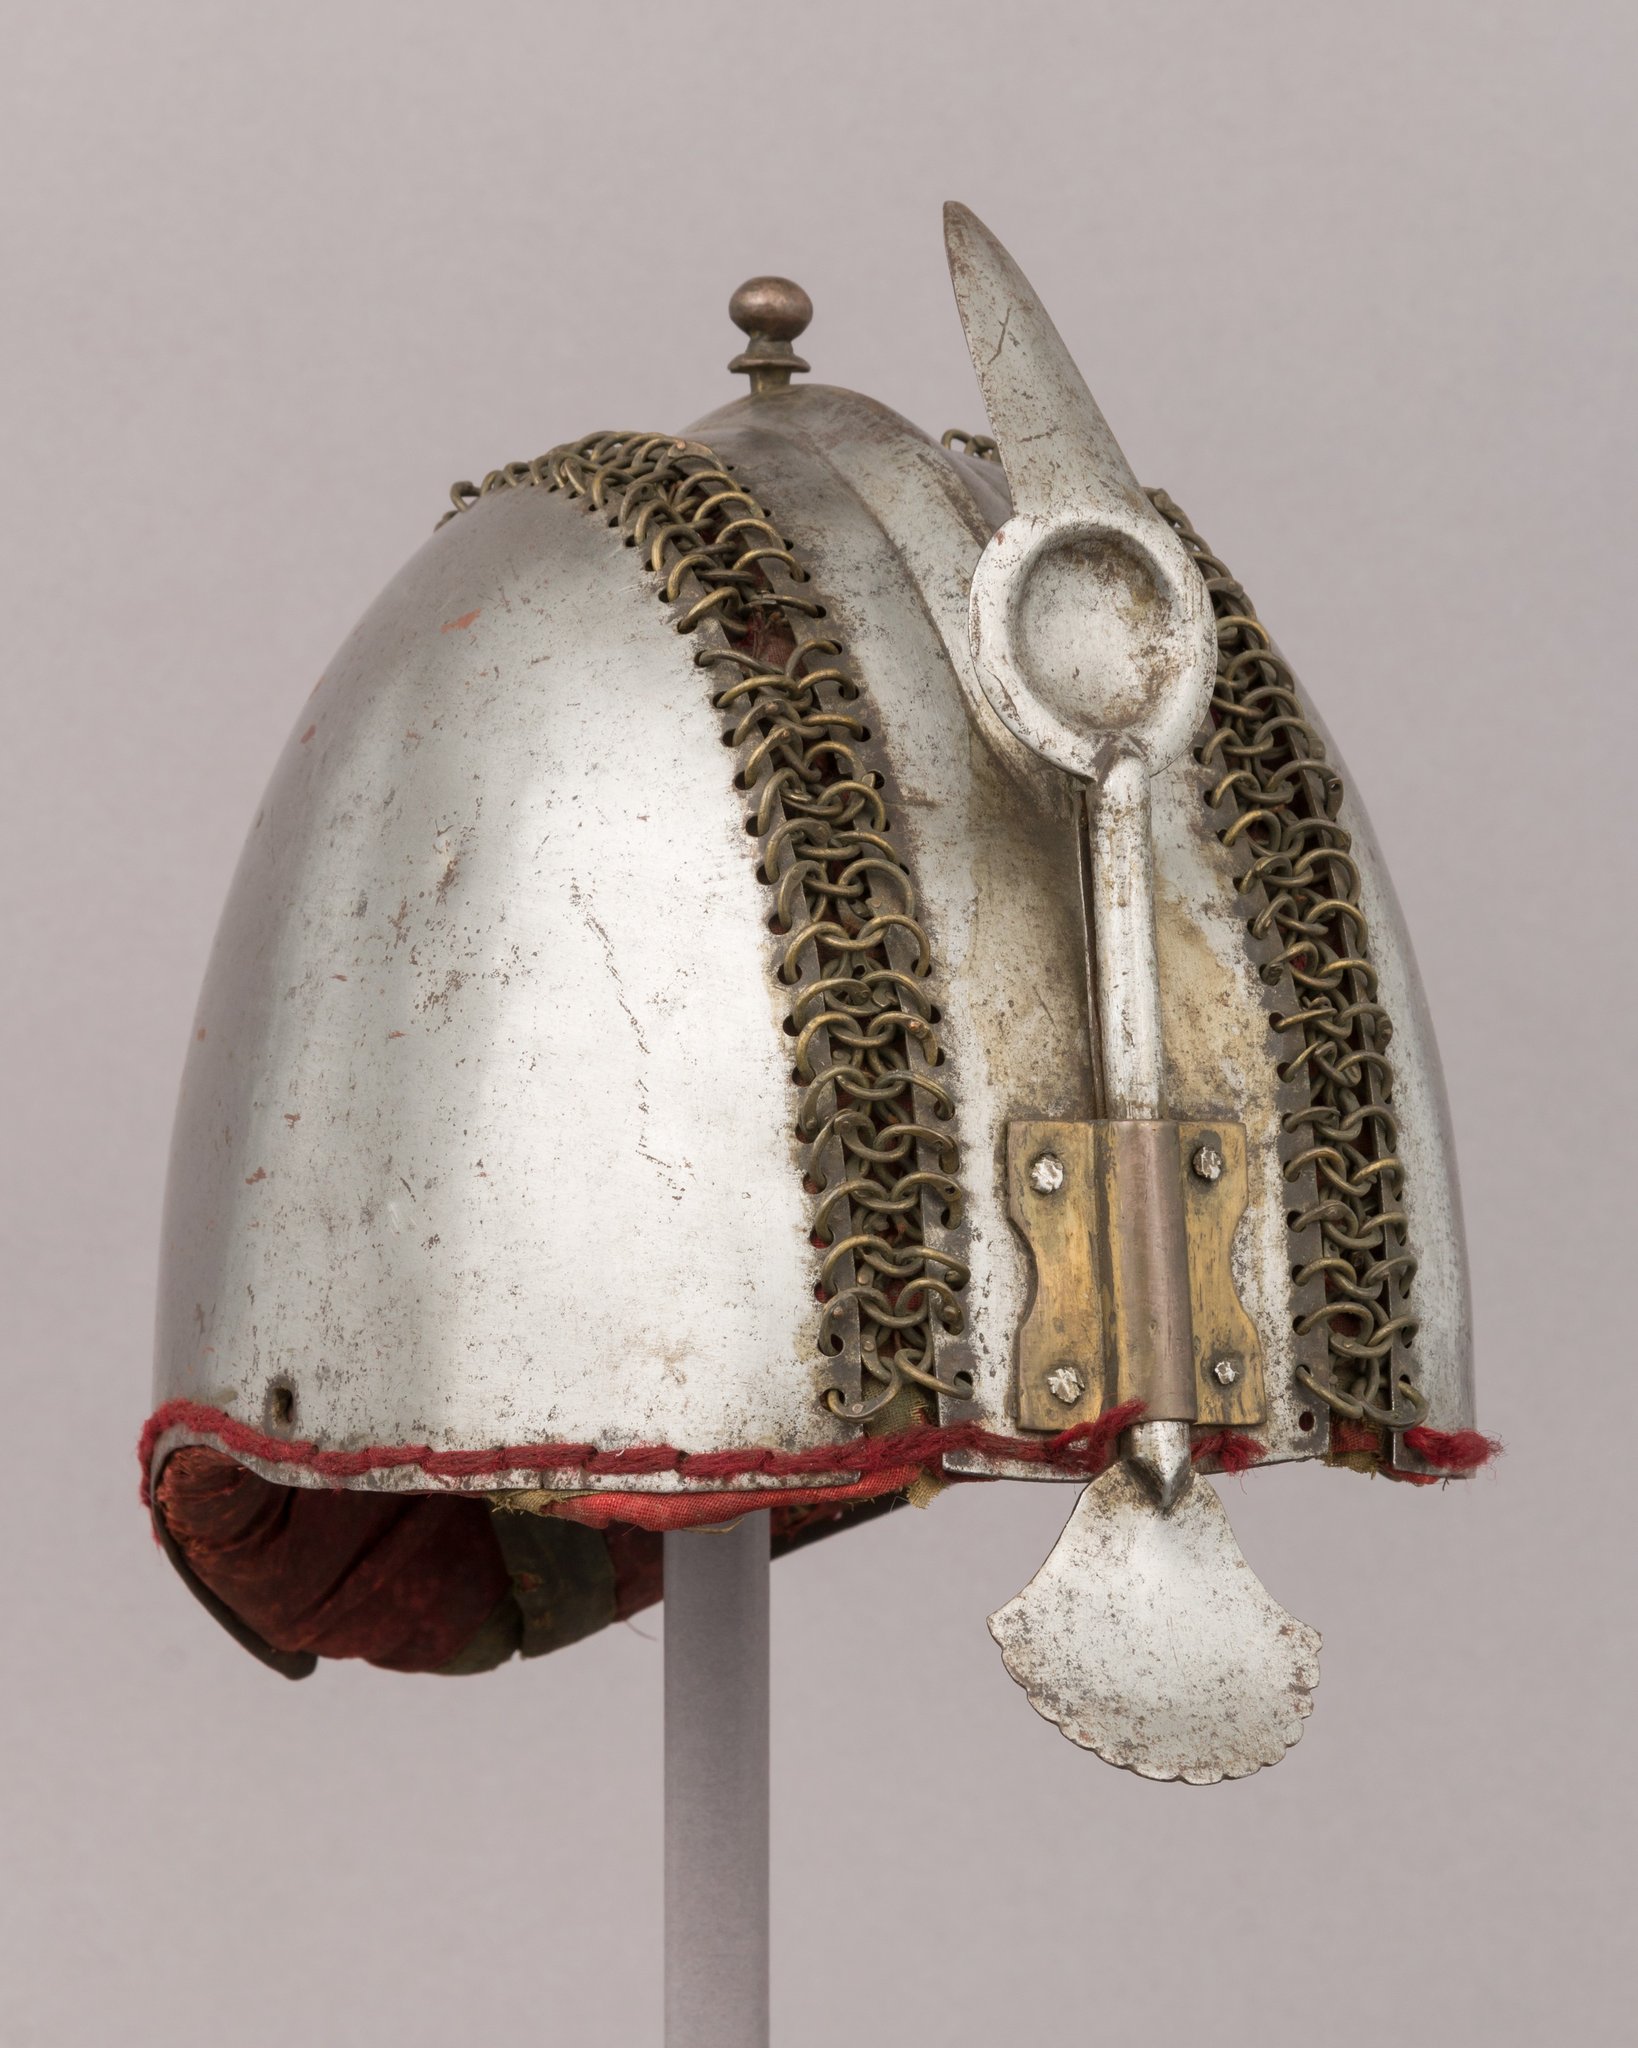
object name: helmet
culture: indian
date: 1701-1900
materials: copper alloy, steel, textile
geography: central india